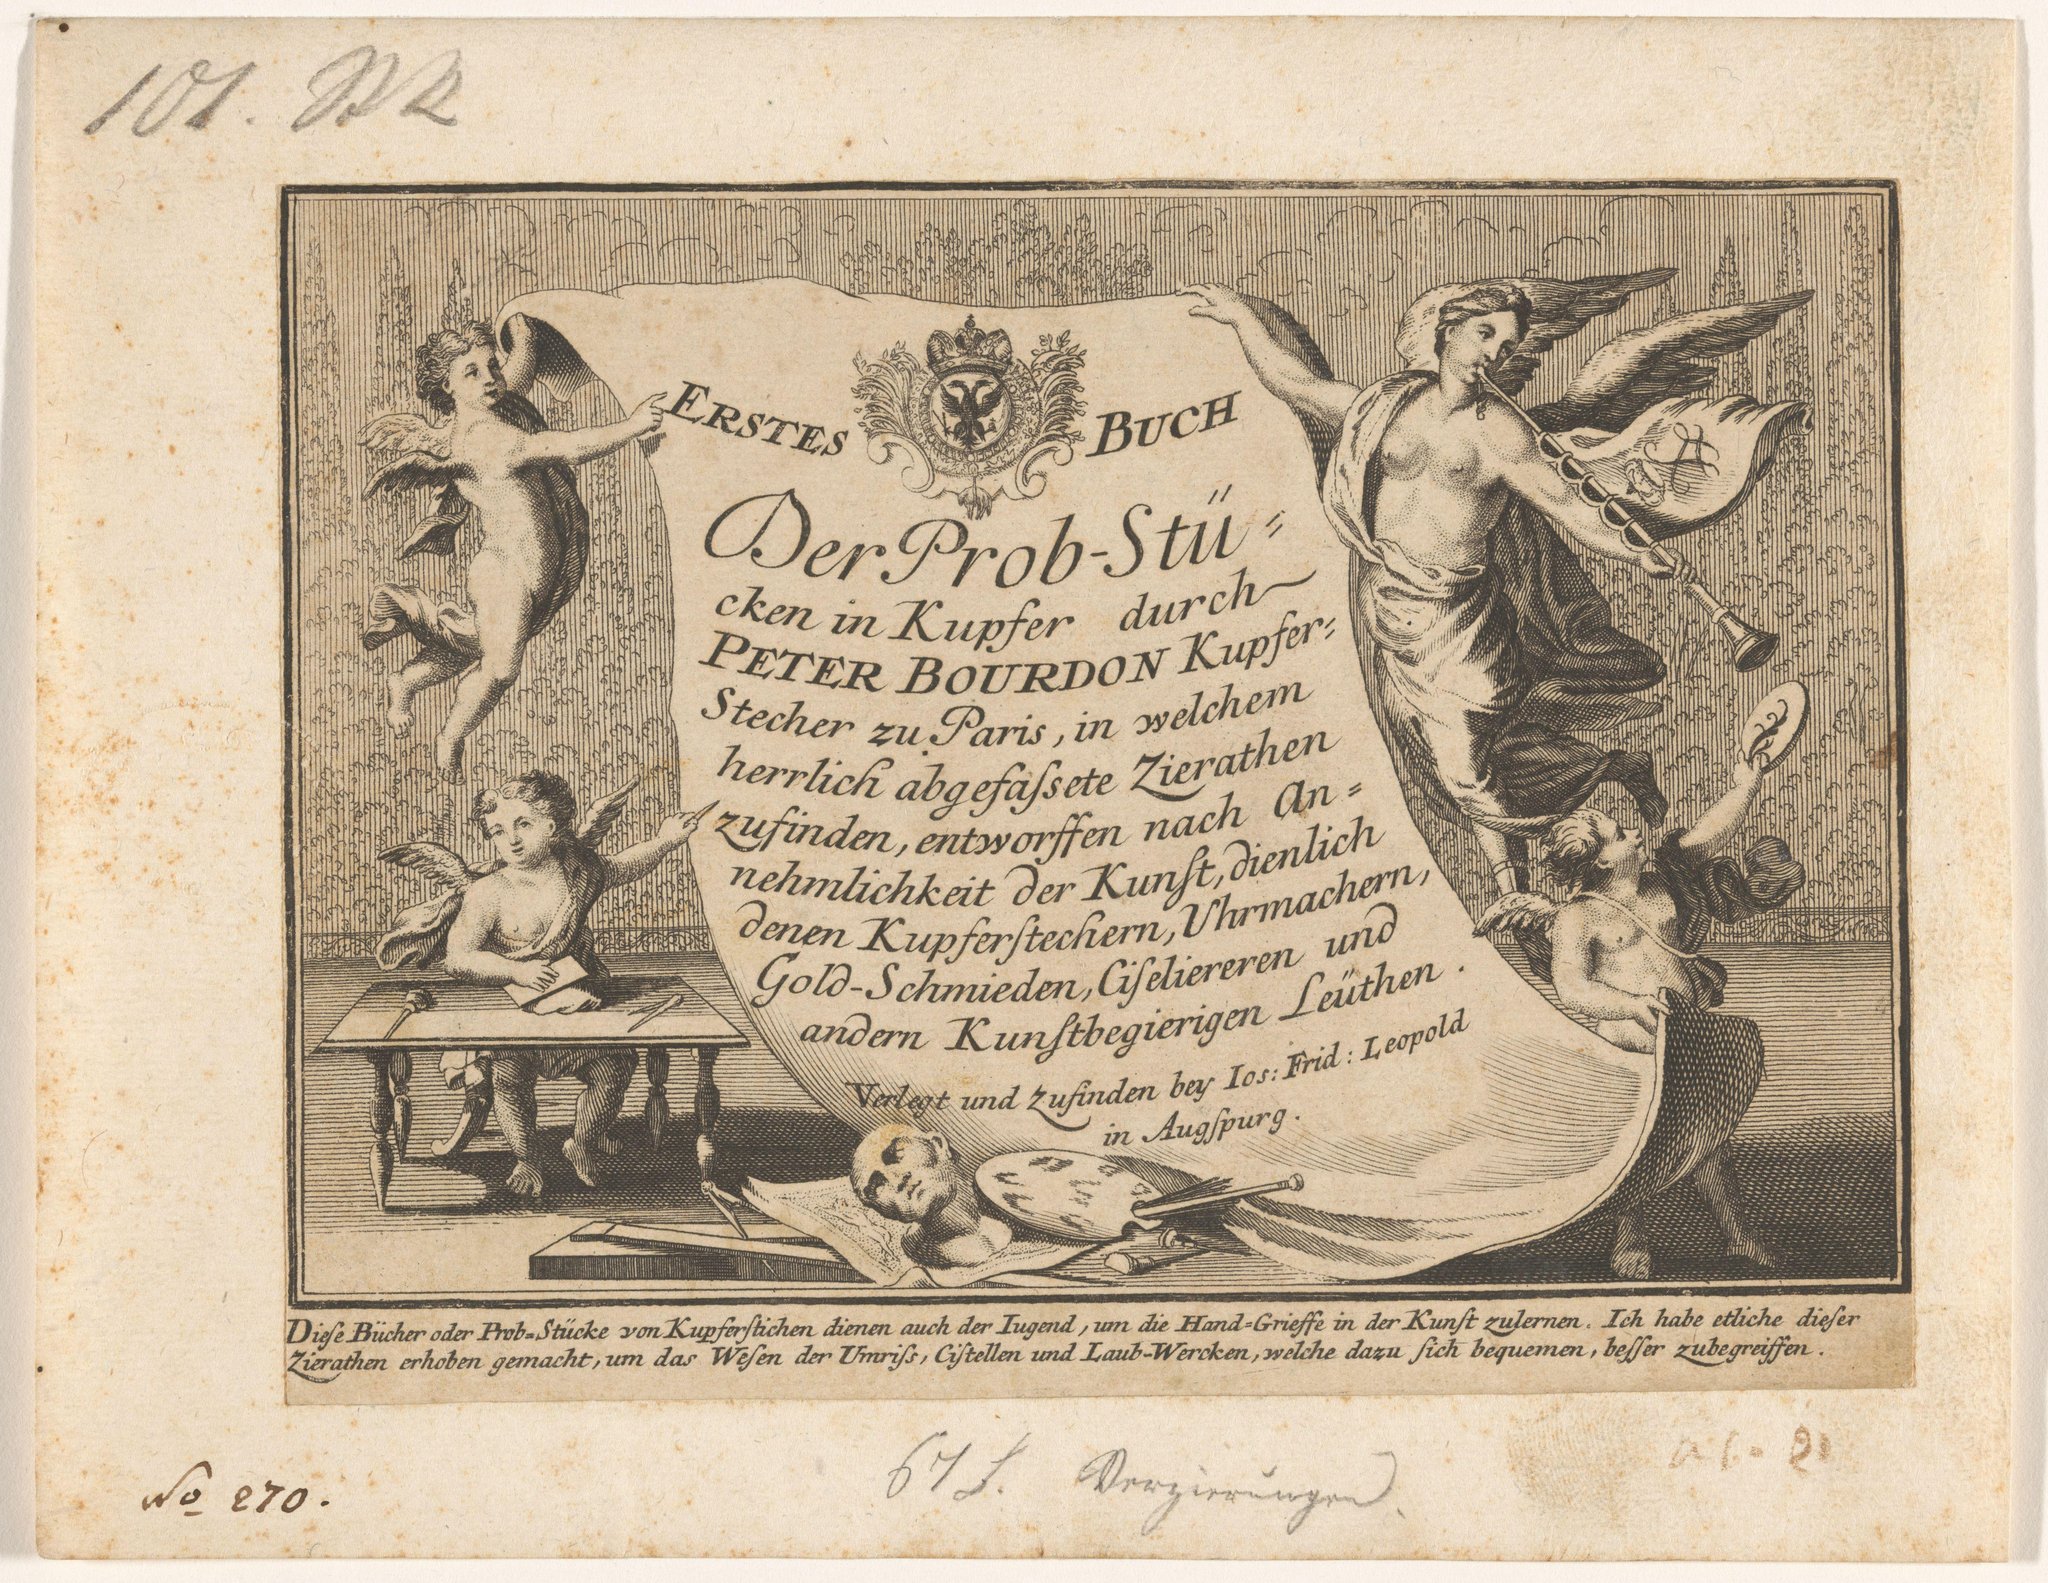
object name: print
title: Titelprent Erstes Buch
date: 1703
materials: paper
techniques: engraving, etching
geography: augsburg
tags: ornaments ~ art, title-page, cupids: 'amores', 'amoretti', 'putti'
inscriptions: collector's mark:, collector's mark: Lugt 2760, collector's mark: Lugt 2228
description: Gespiegelde Duitse kopie van Pierre Bourdon's Livre Premier: Essais de gravure (1703). Titelprent uit serie van zeven van ontwerpen voor horlogemakers, goudsmeden, beeldhouwers en graveurs.